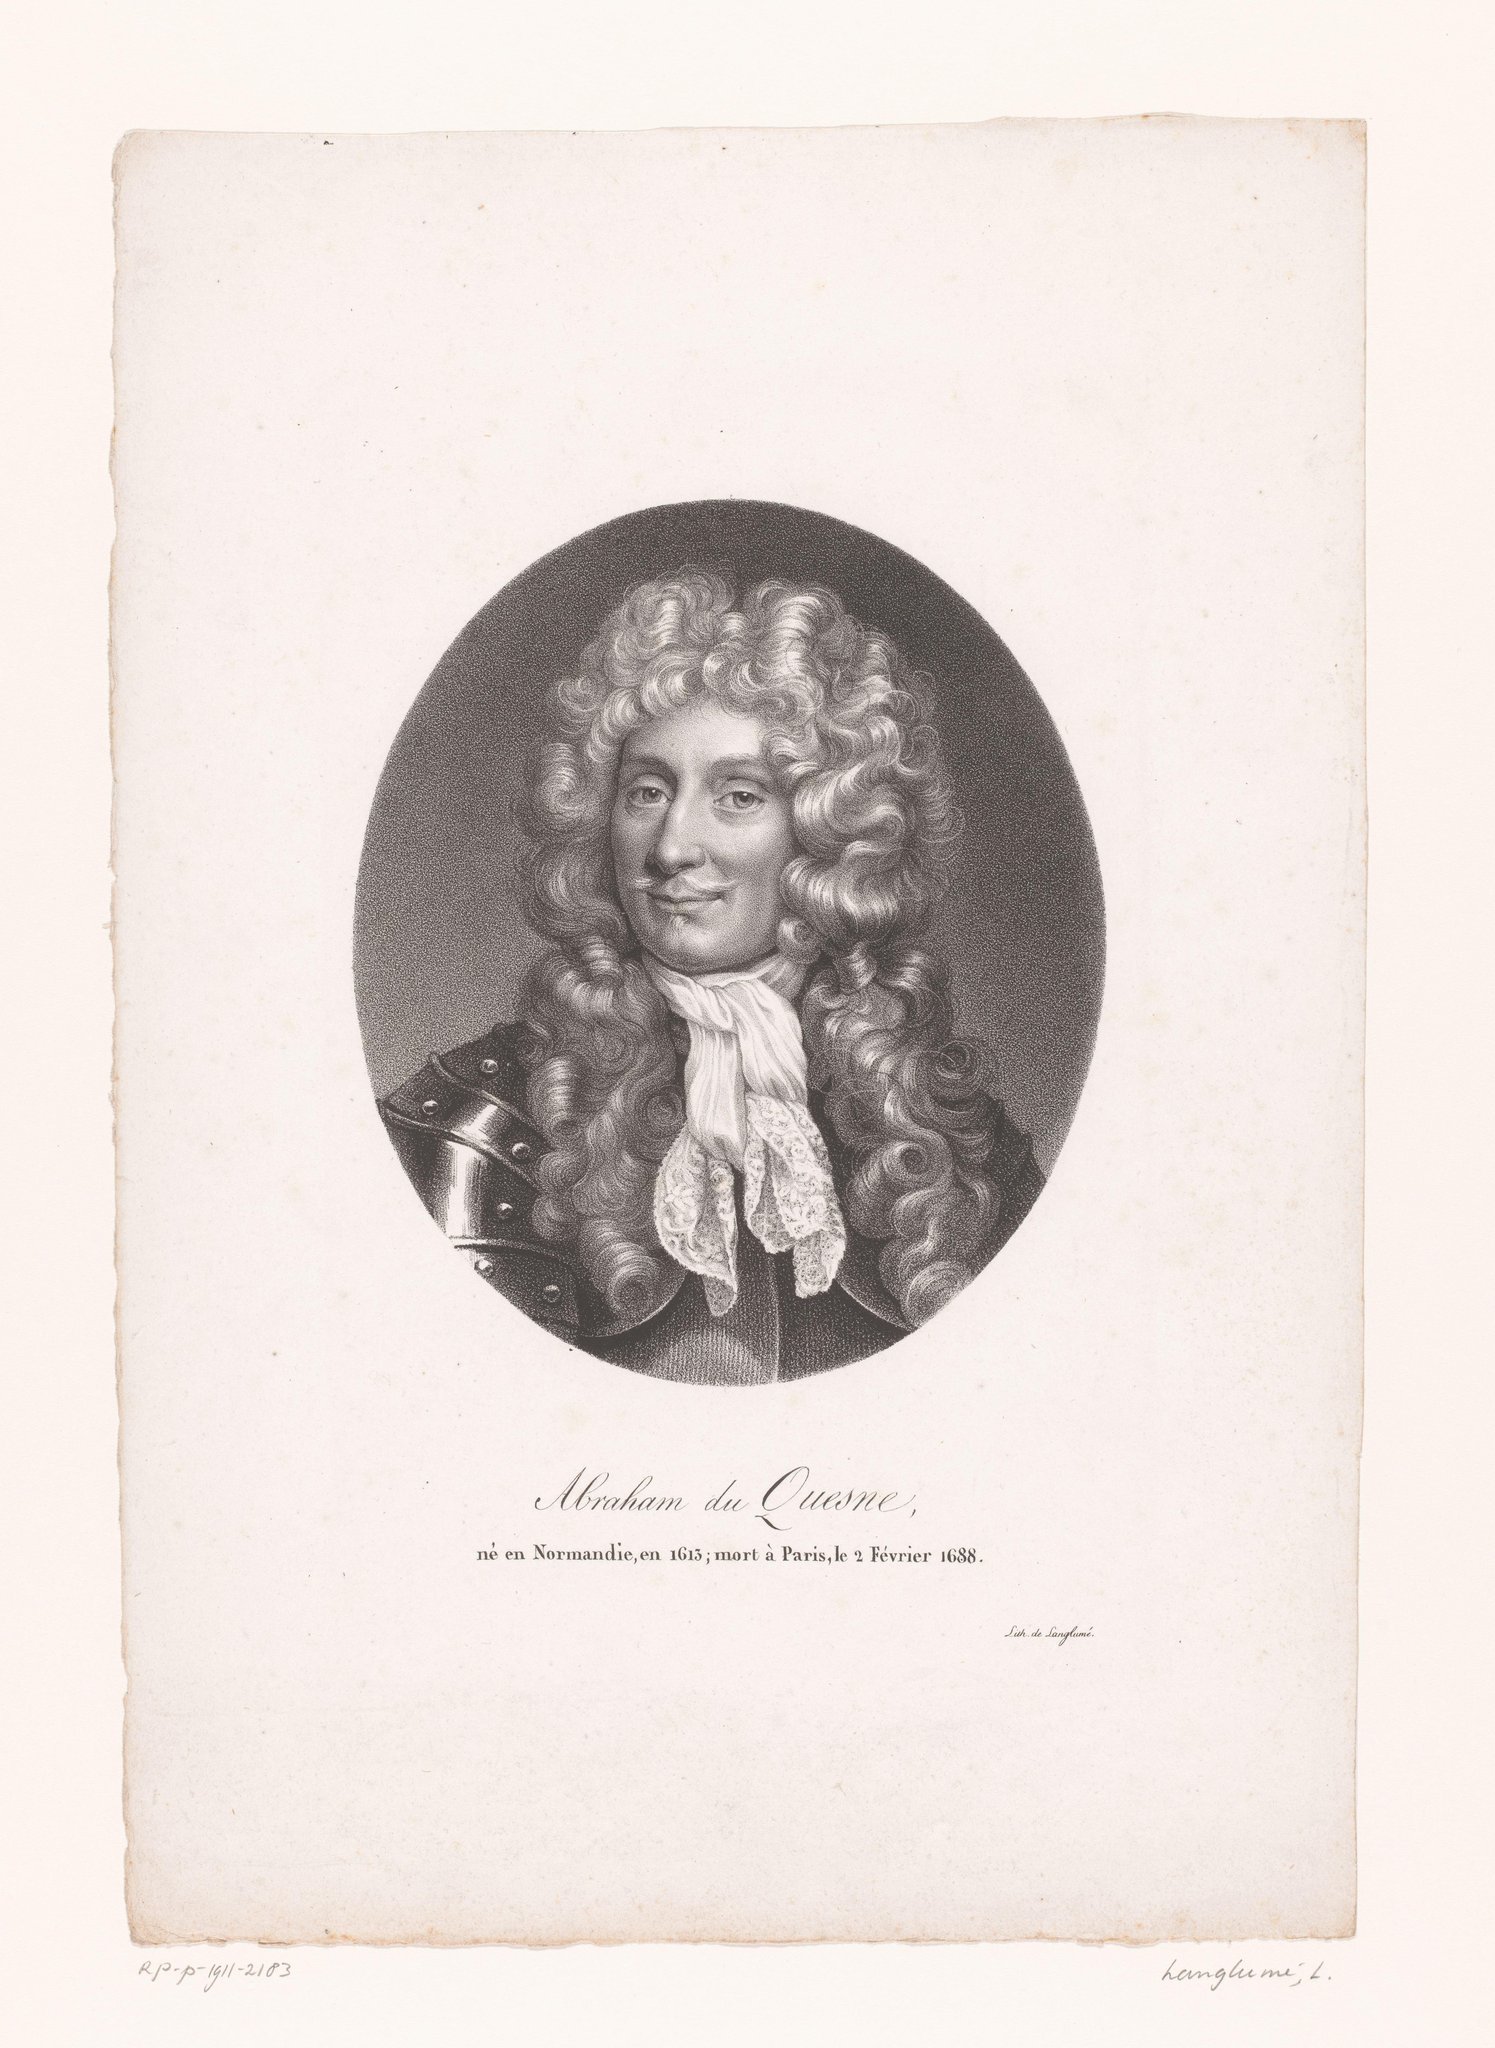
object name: print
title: Abraham du Quesne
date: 1820-1830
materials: paper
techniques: lithograph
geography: paris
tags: paris, historical persons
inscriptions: collector's mark: Lugt 2228a